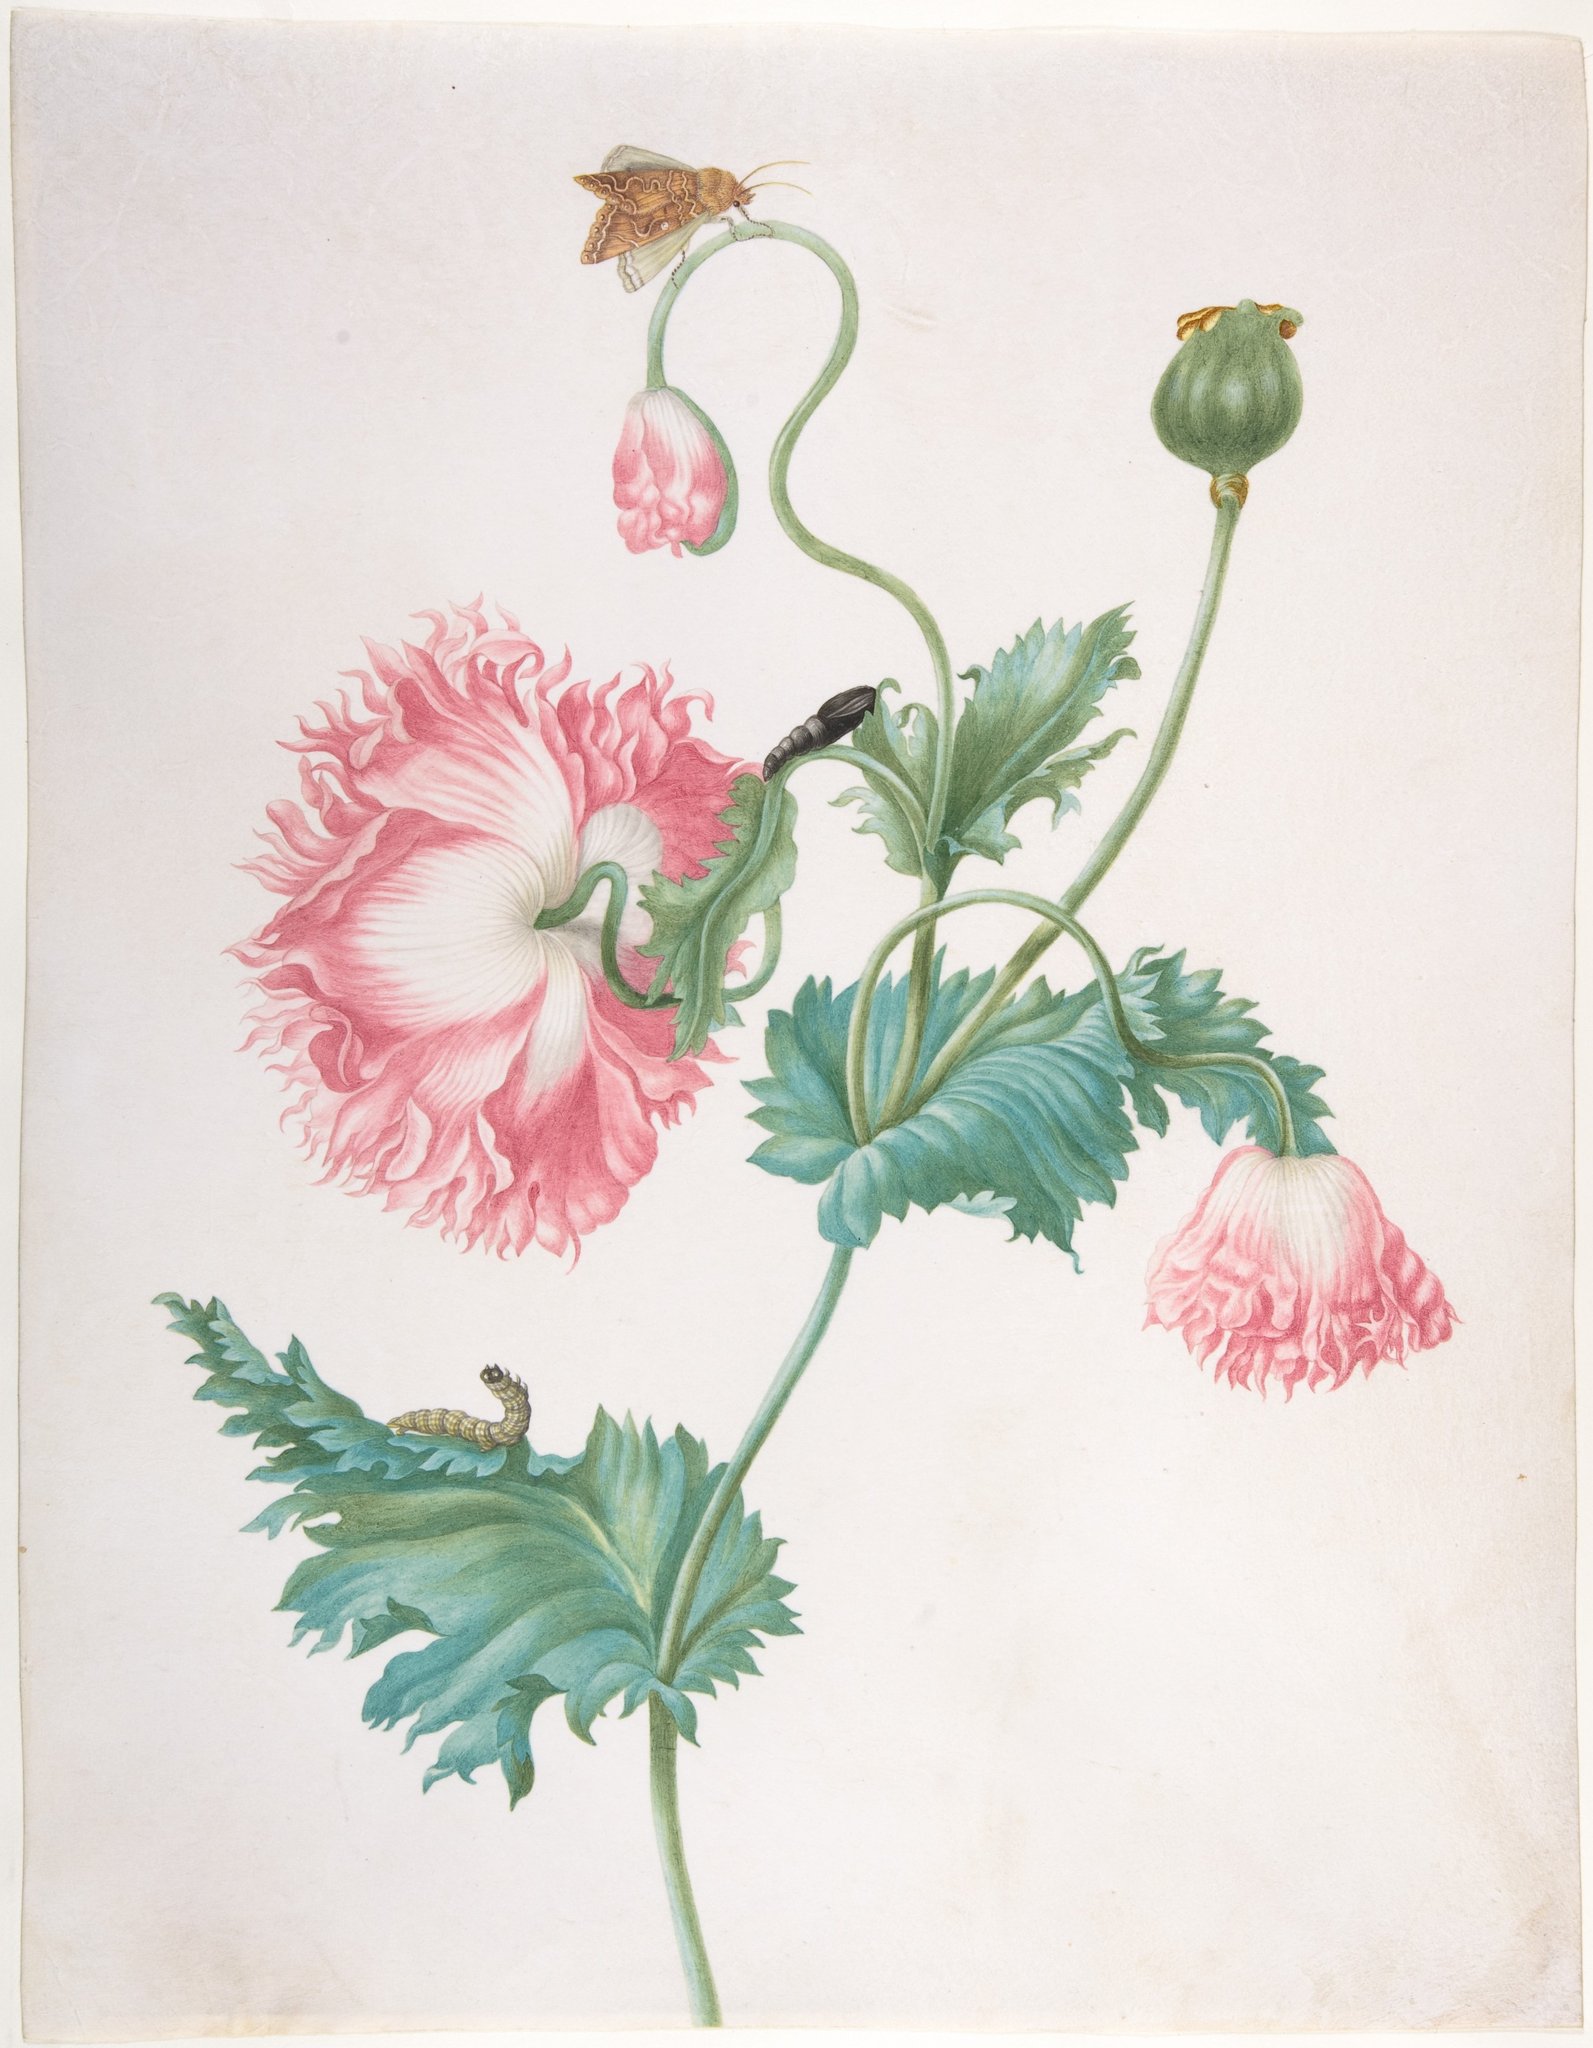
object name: drawing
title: A Poppy in Three Stages of Flowering, with a Caterpillar, Pupa and Butterfly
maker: johanna helena herolt (née graff)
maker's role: artist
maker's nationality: german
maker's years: 1668-1723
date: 1667-1733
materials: chalk, gouache, watercolor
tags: butterflies,poppies,leaves